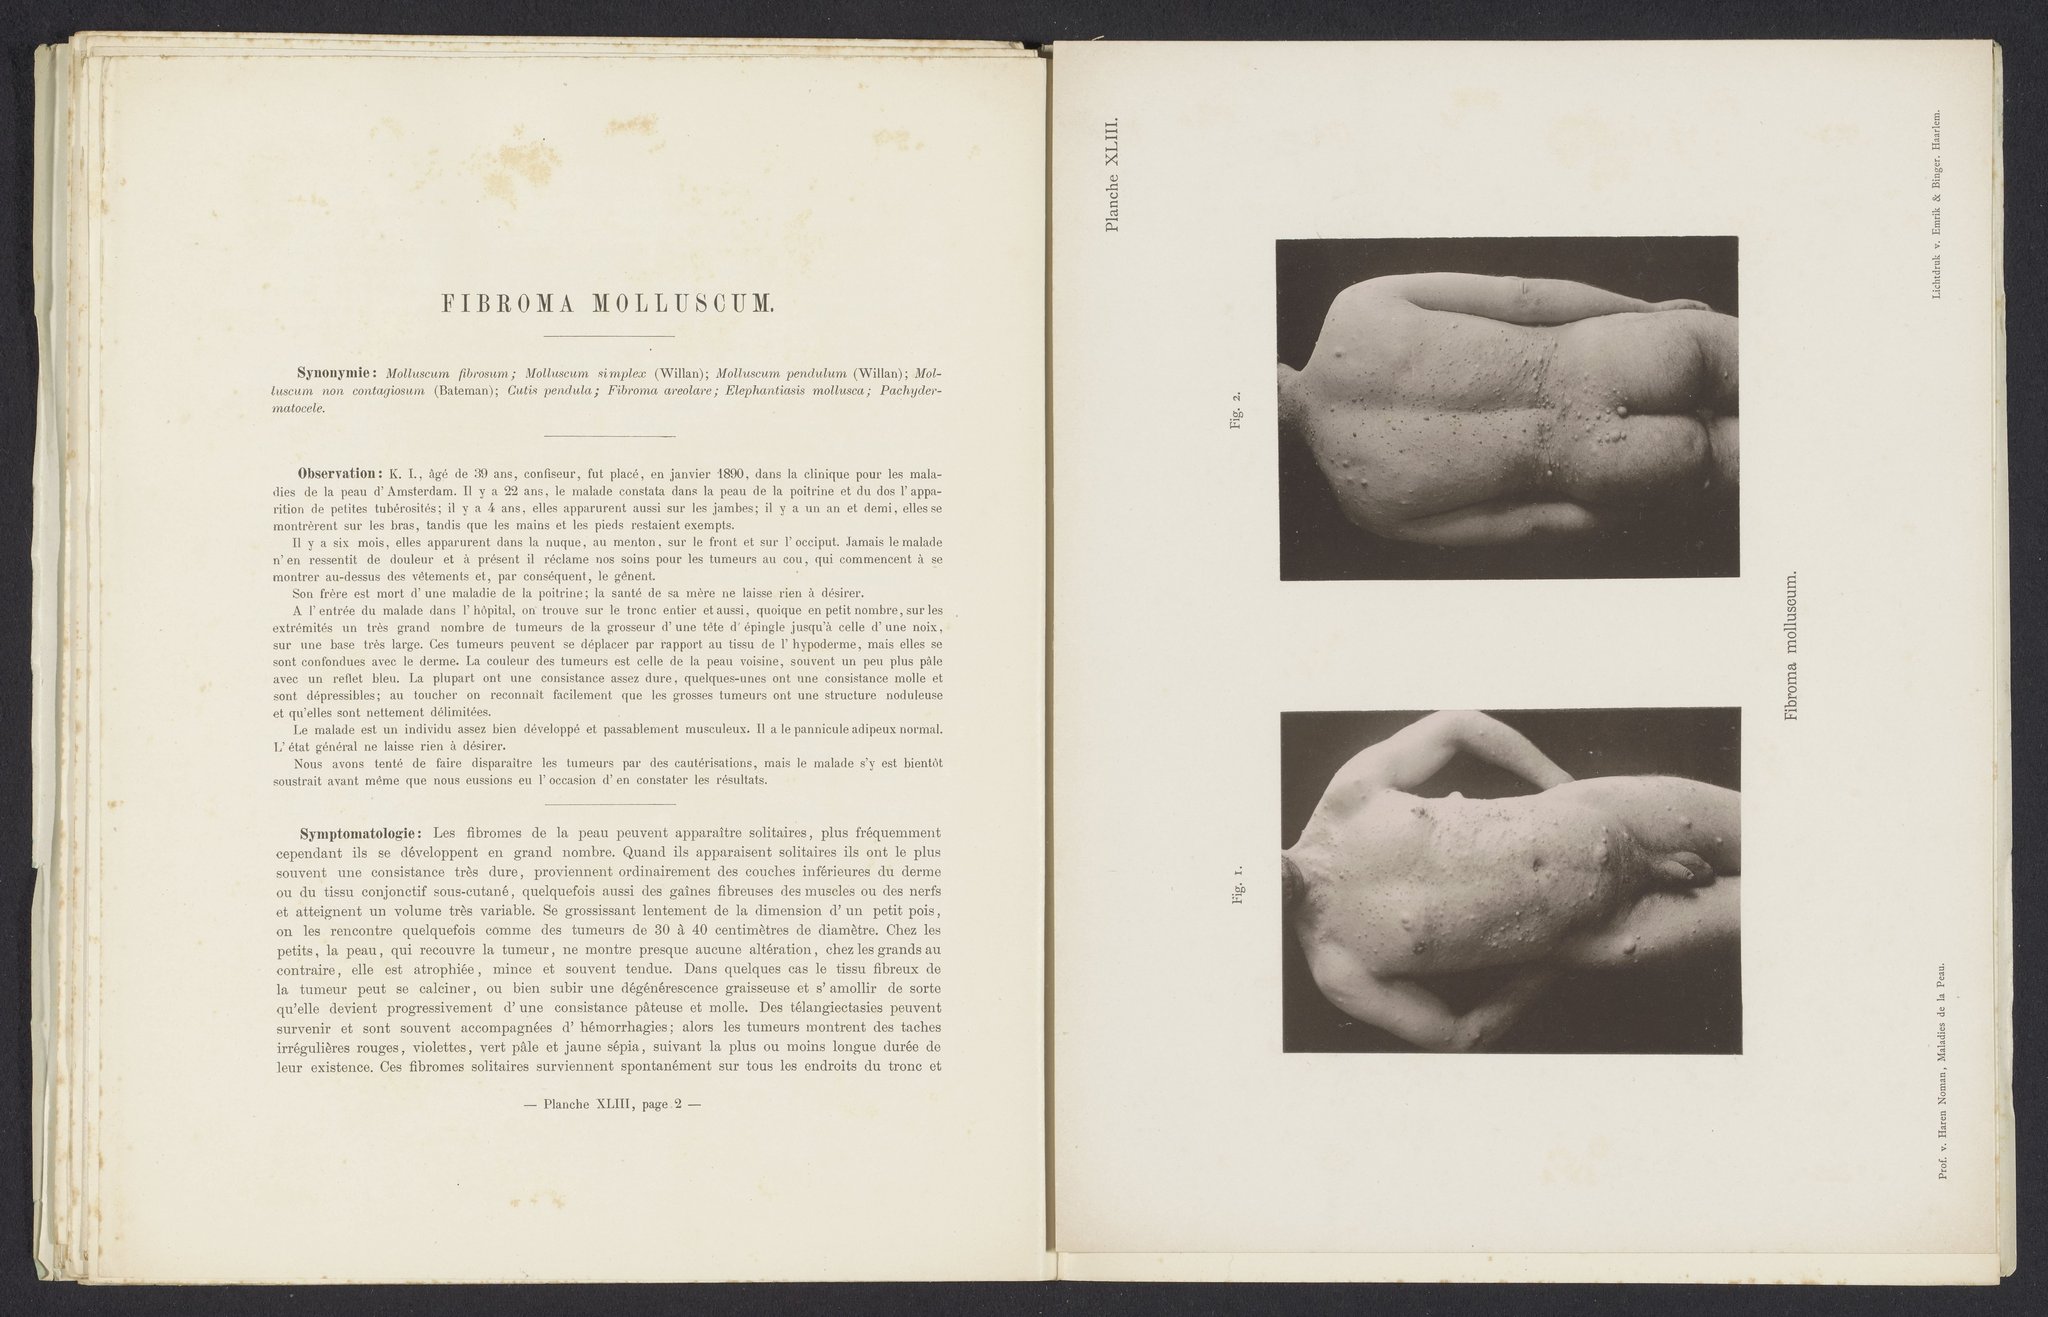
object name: page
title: Fibroma molluscum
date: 1883-1893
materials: paper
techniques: photograph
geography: amsterdam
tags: chest, bust, skin and venereal diseases, male sexual organs, adult man, back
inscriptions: number: ‘Planche XLIII. / Fig. 1. / Fig. 2.’